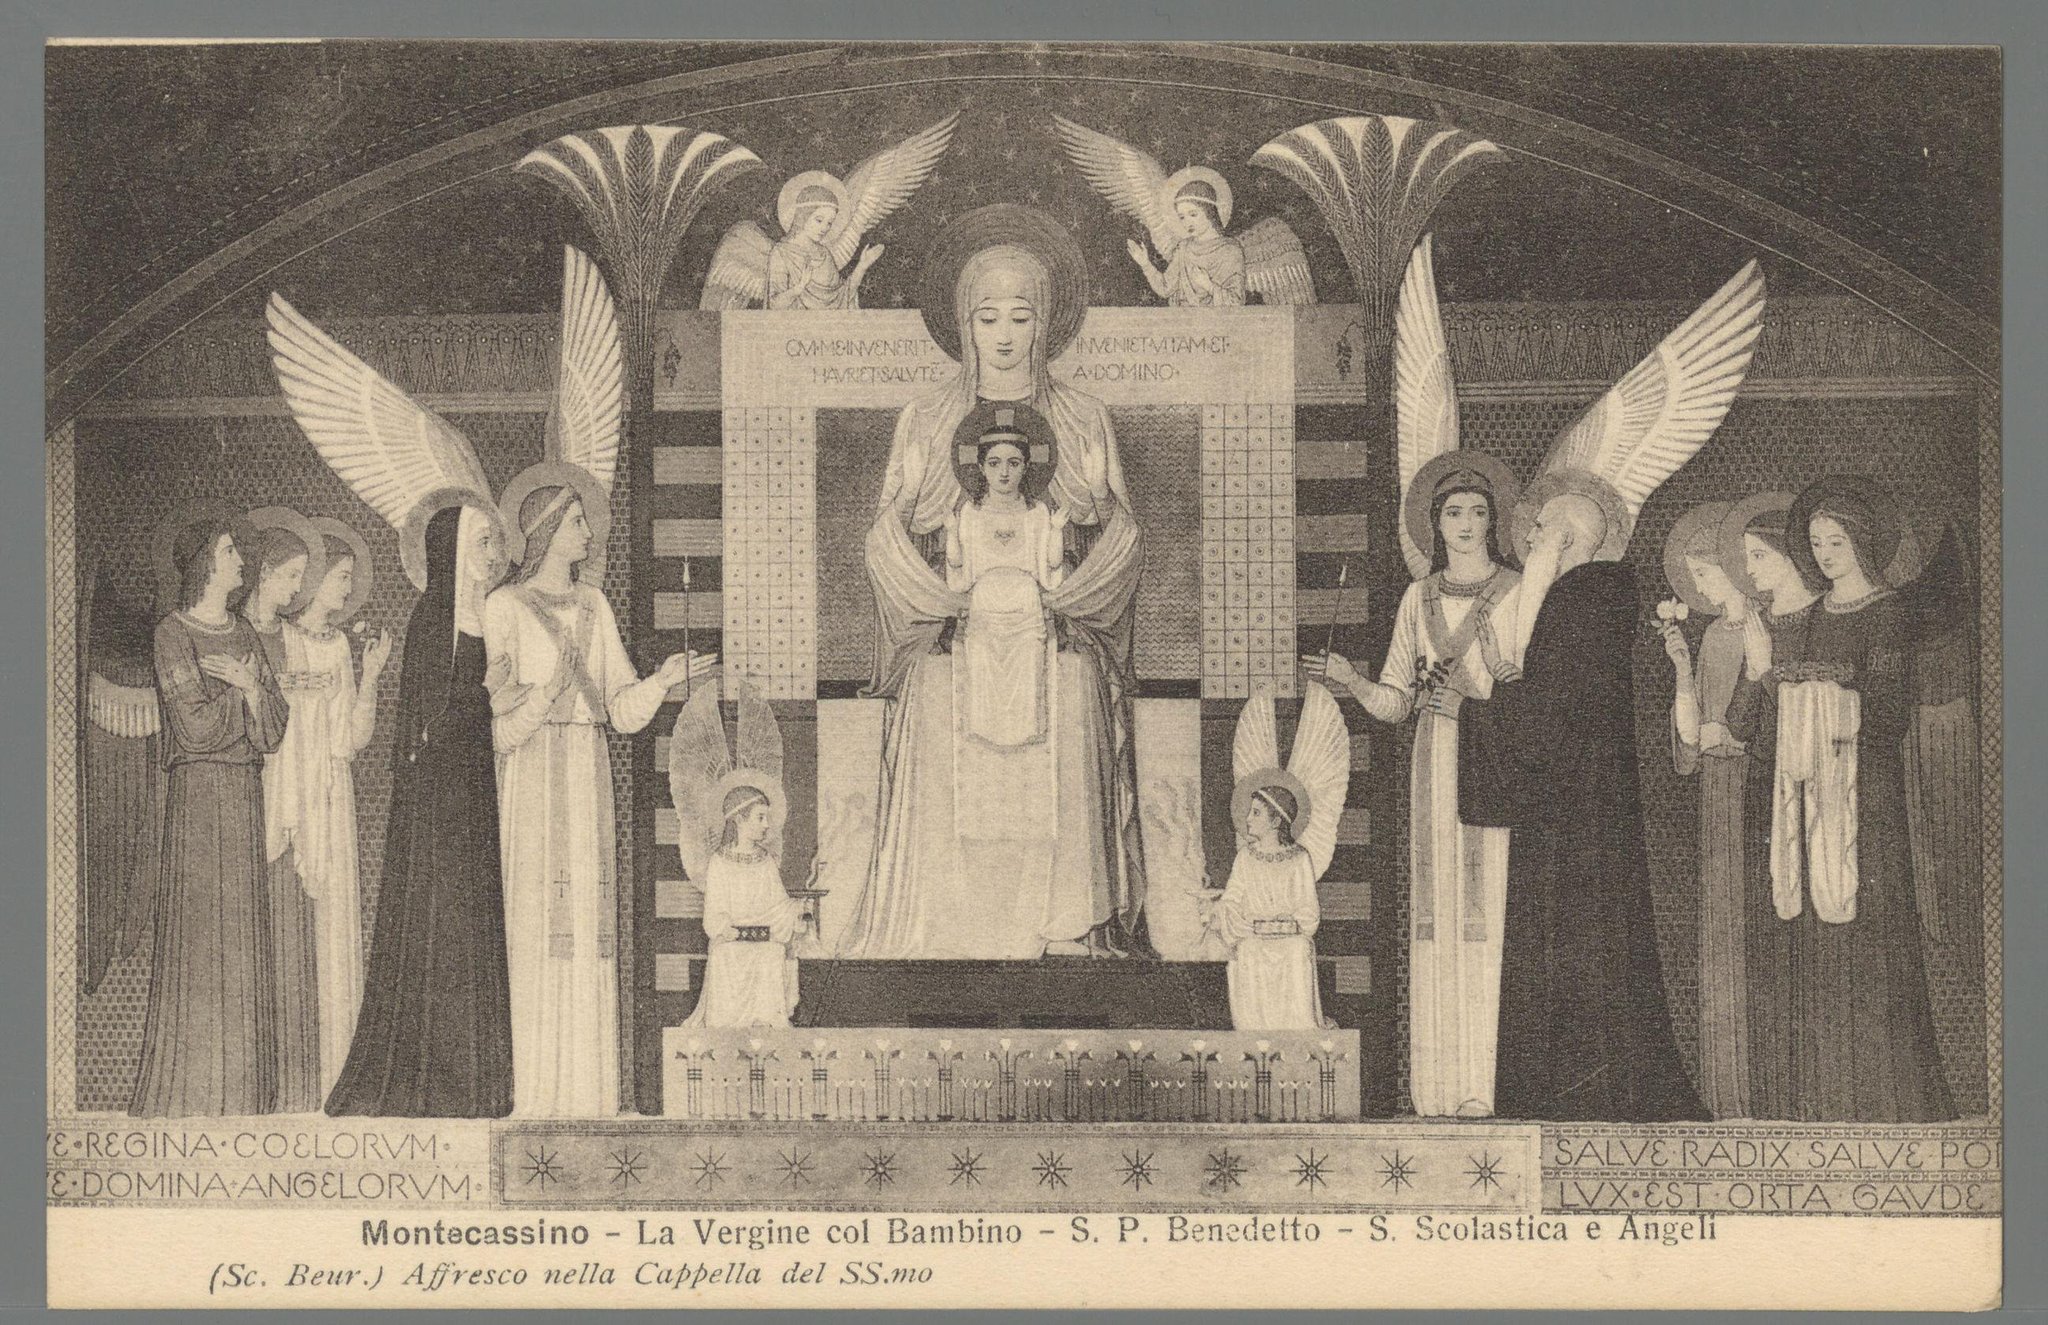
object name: ansichtkaart, prentbriefkaart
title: Montecassino. La Vergine col Bambino (...) Affresco nella Cappella del SS.mo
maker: Anonymous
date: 1906-1910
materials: cardboard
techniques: photograph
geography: terni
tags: madonna: i.e. mary with the christ-child (+ angel(s)), interior of church, picture, painting